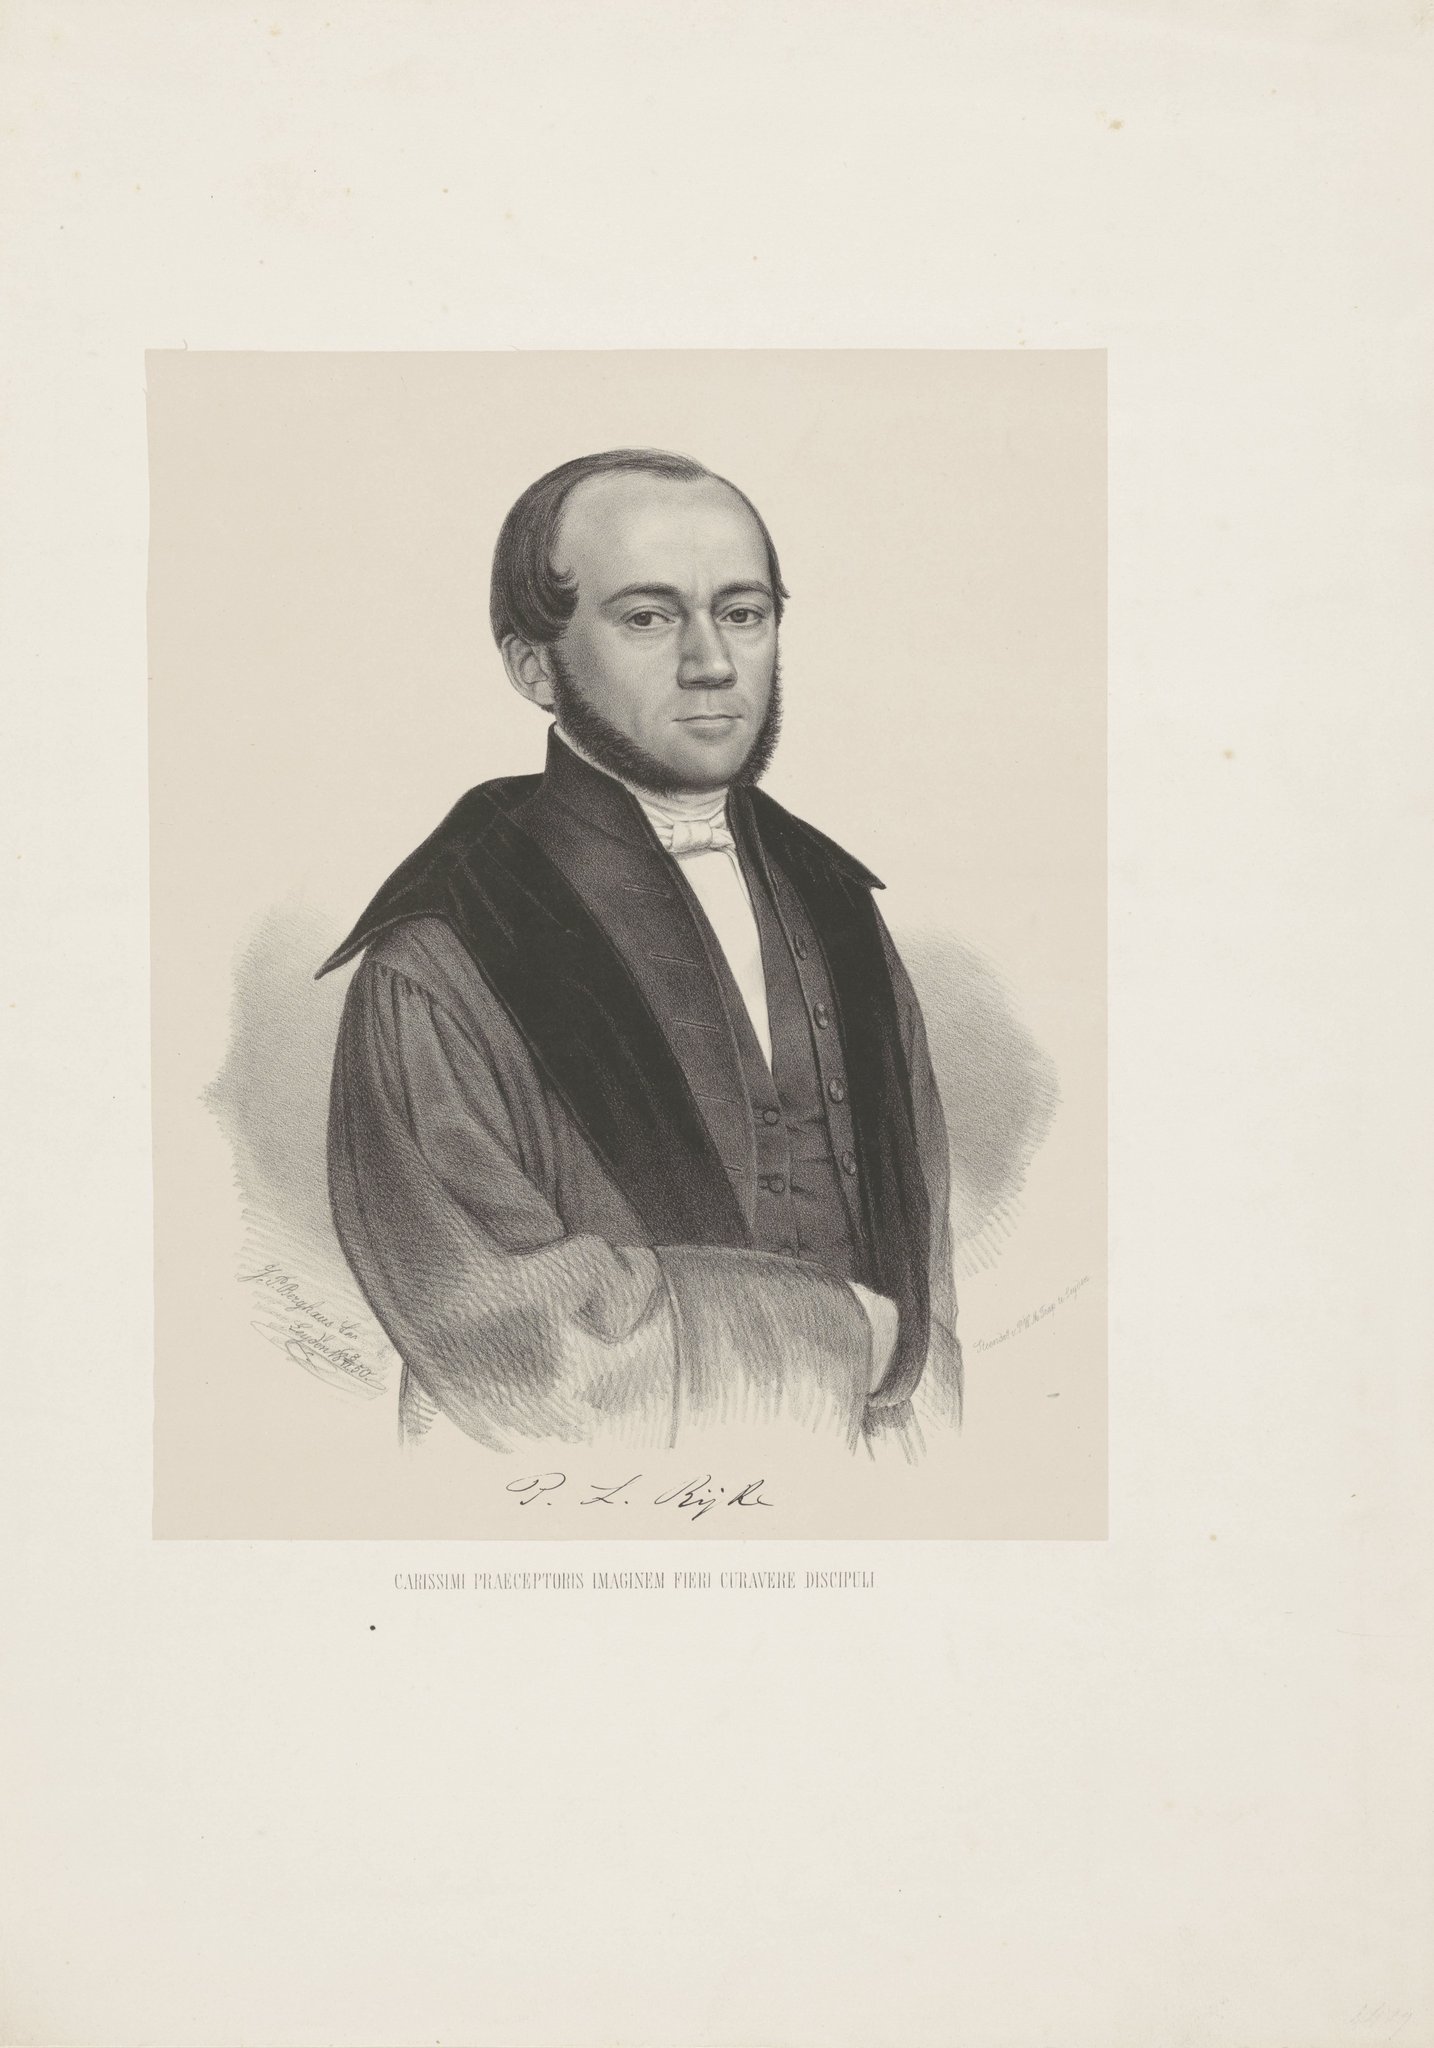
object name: print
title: Portret van Pieter Leonard Rijke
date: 1850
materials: paper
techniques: lithograph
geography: leiden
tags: physicist, historical persons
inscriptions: date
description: De geportretteerde draagt een toga. Zijn rechterhand heeft hij in zijn jas gestoken. Onder het portret zijn signatuur en een onderschrift in Latijn.